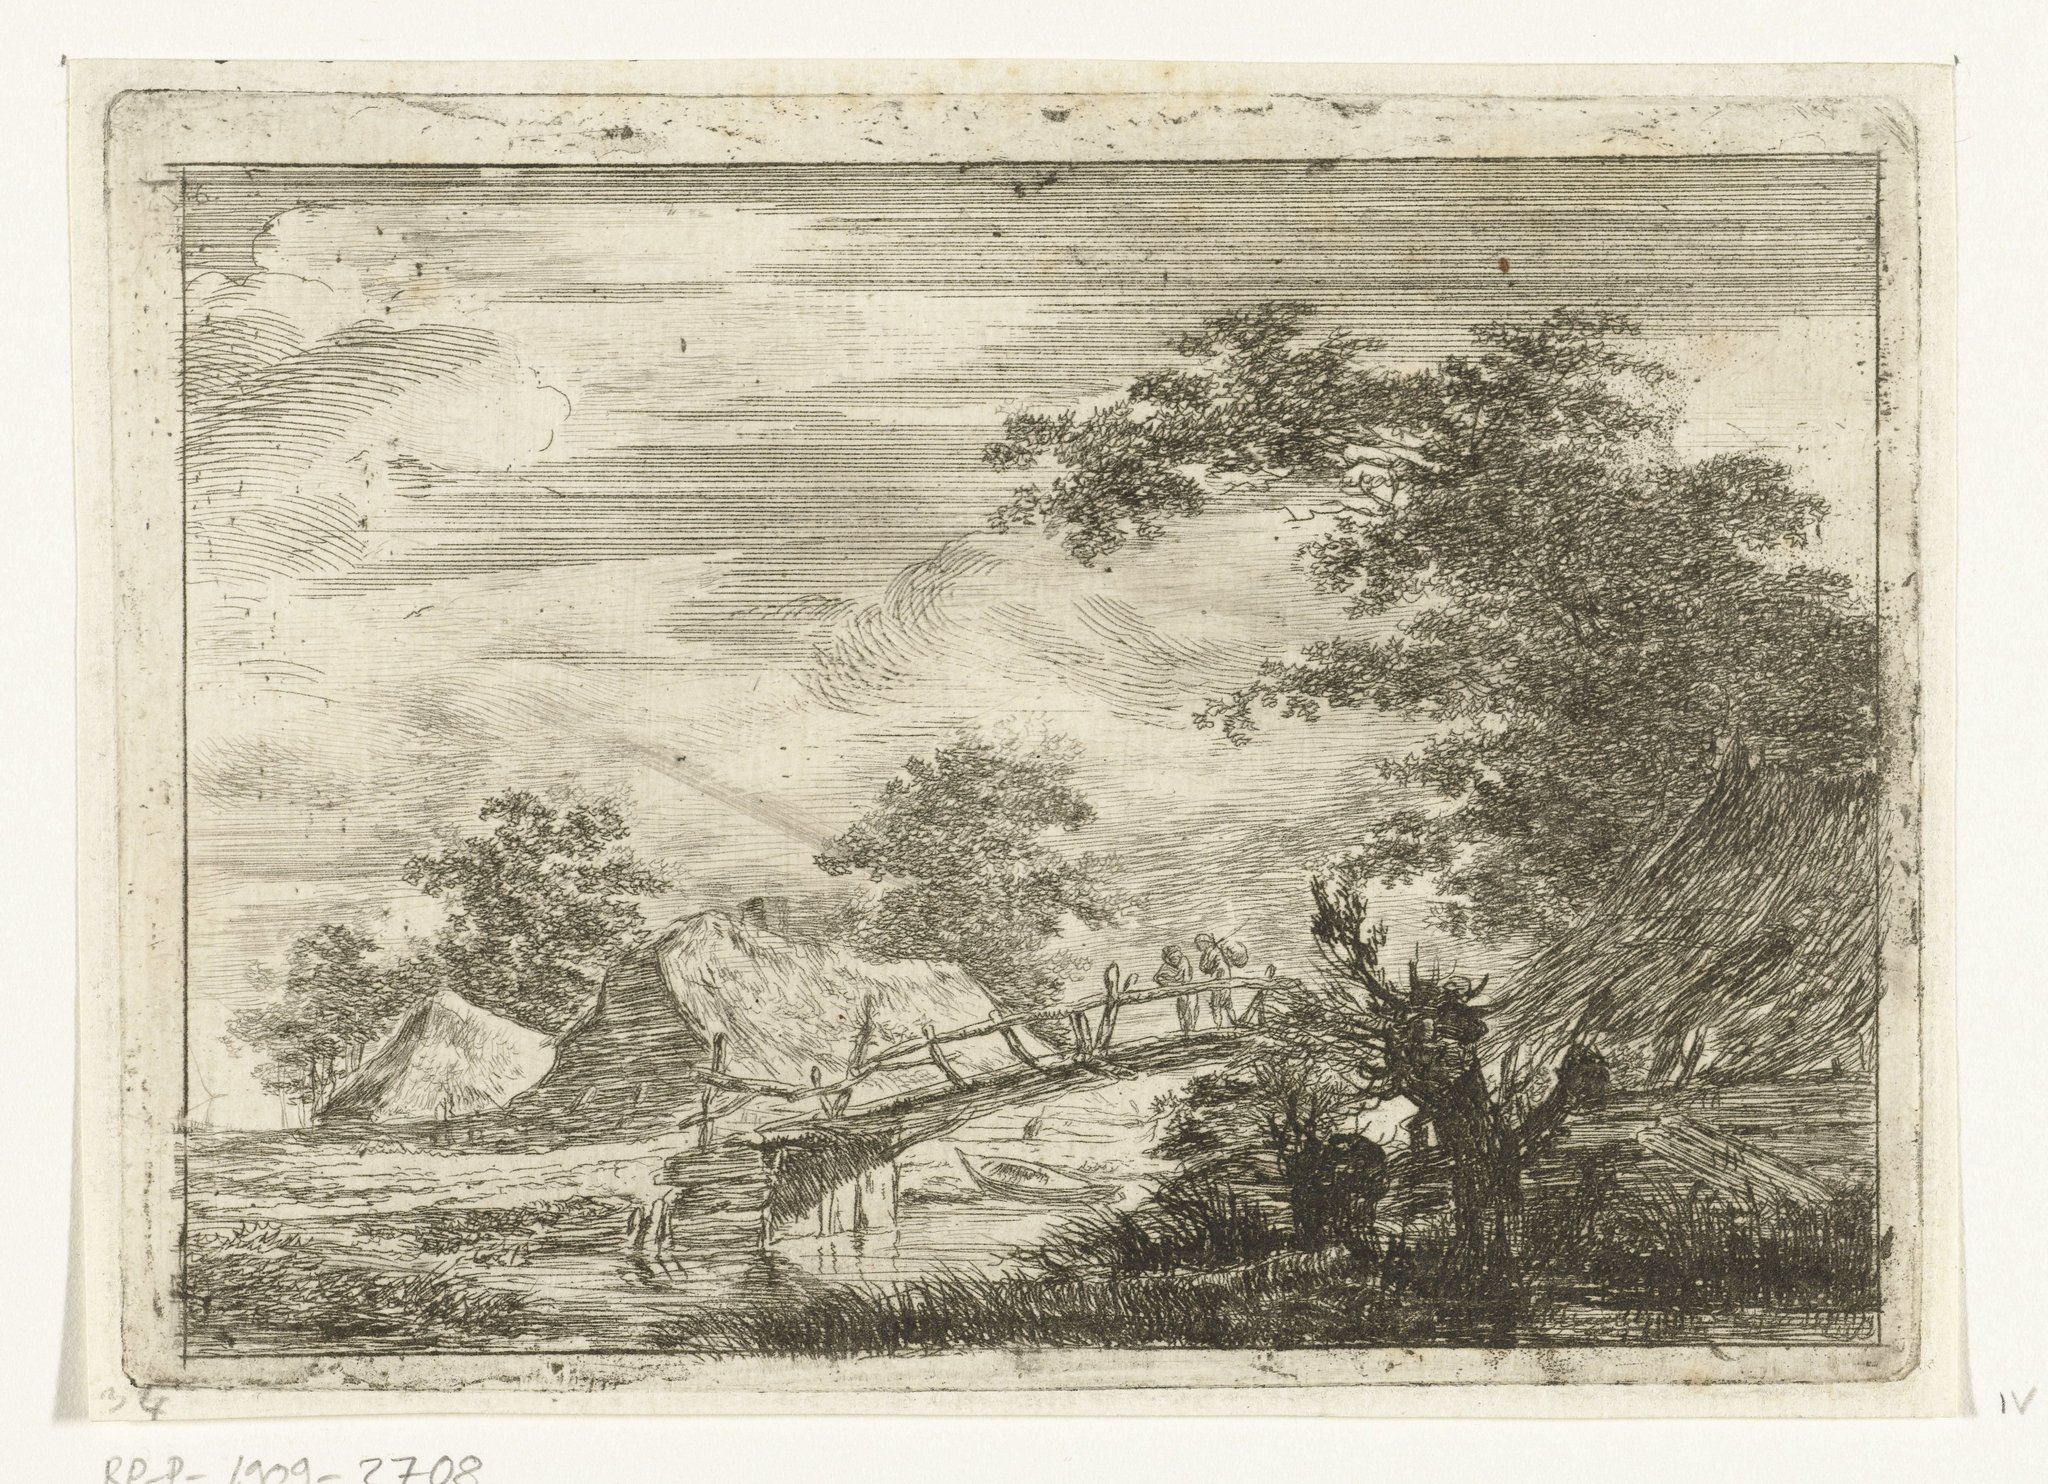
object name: print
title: Houten brug bij huizen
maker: hermanus van brussel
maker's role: draughtsman, print maker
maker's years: 1763-1815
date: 1800-1815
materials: paper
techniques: etching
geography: netherlands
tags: landscapes in the temperate zone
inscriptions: collector's mark: Lugt 2228, collector's mark: Lugt 1485